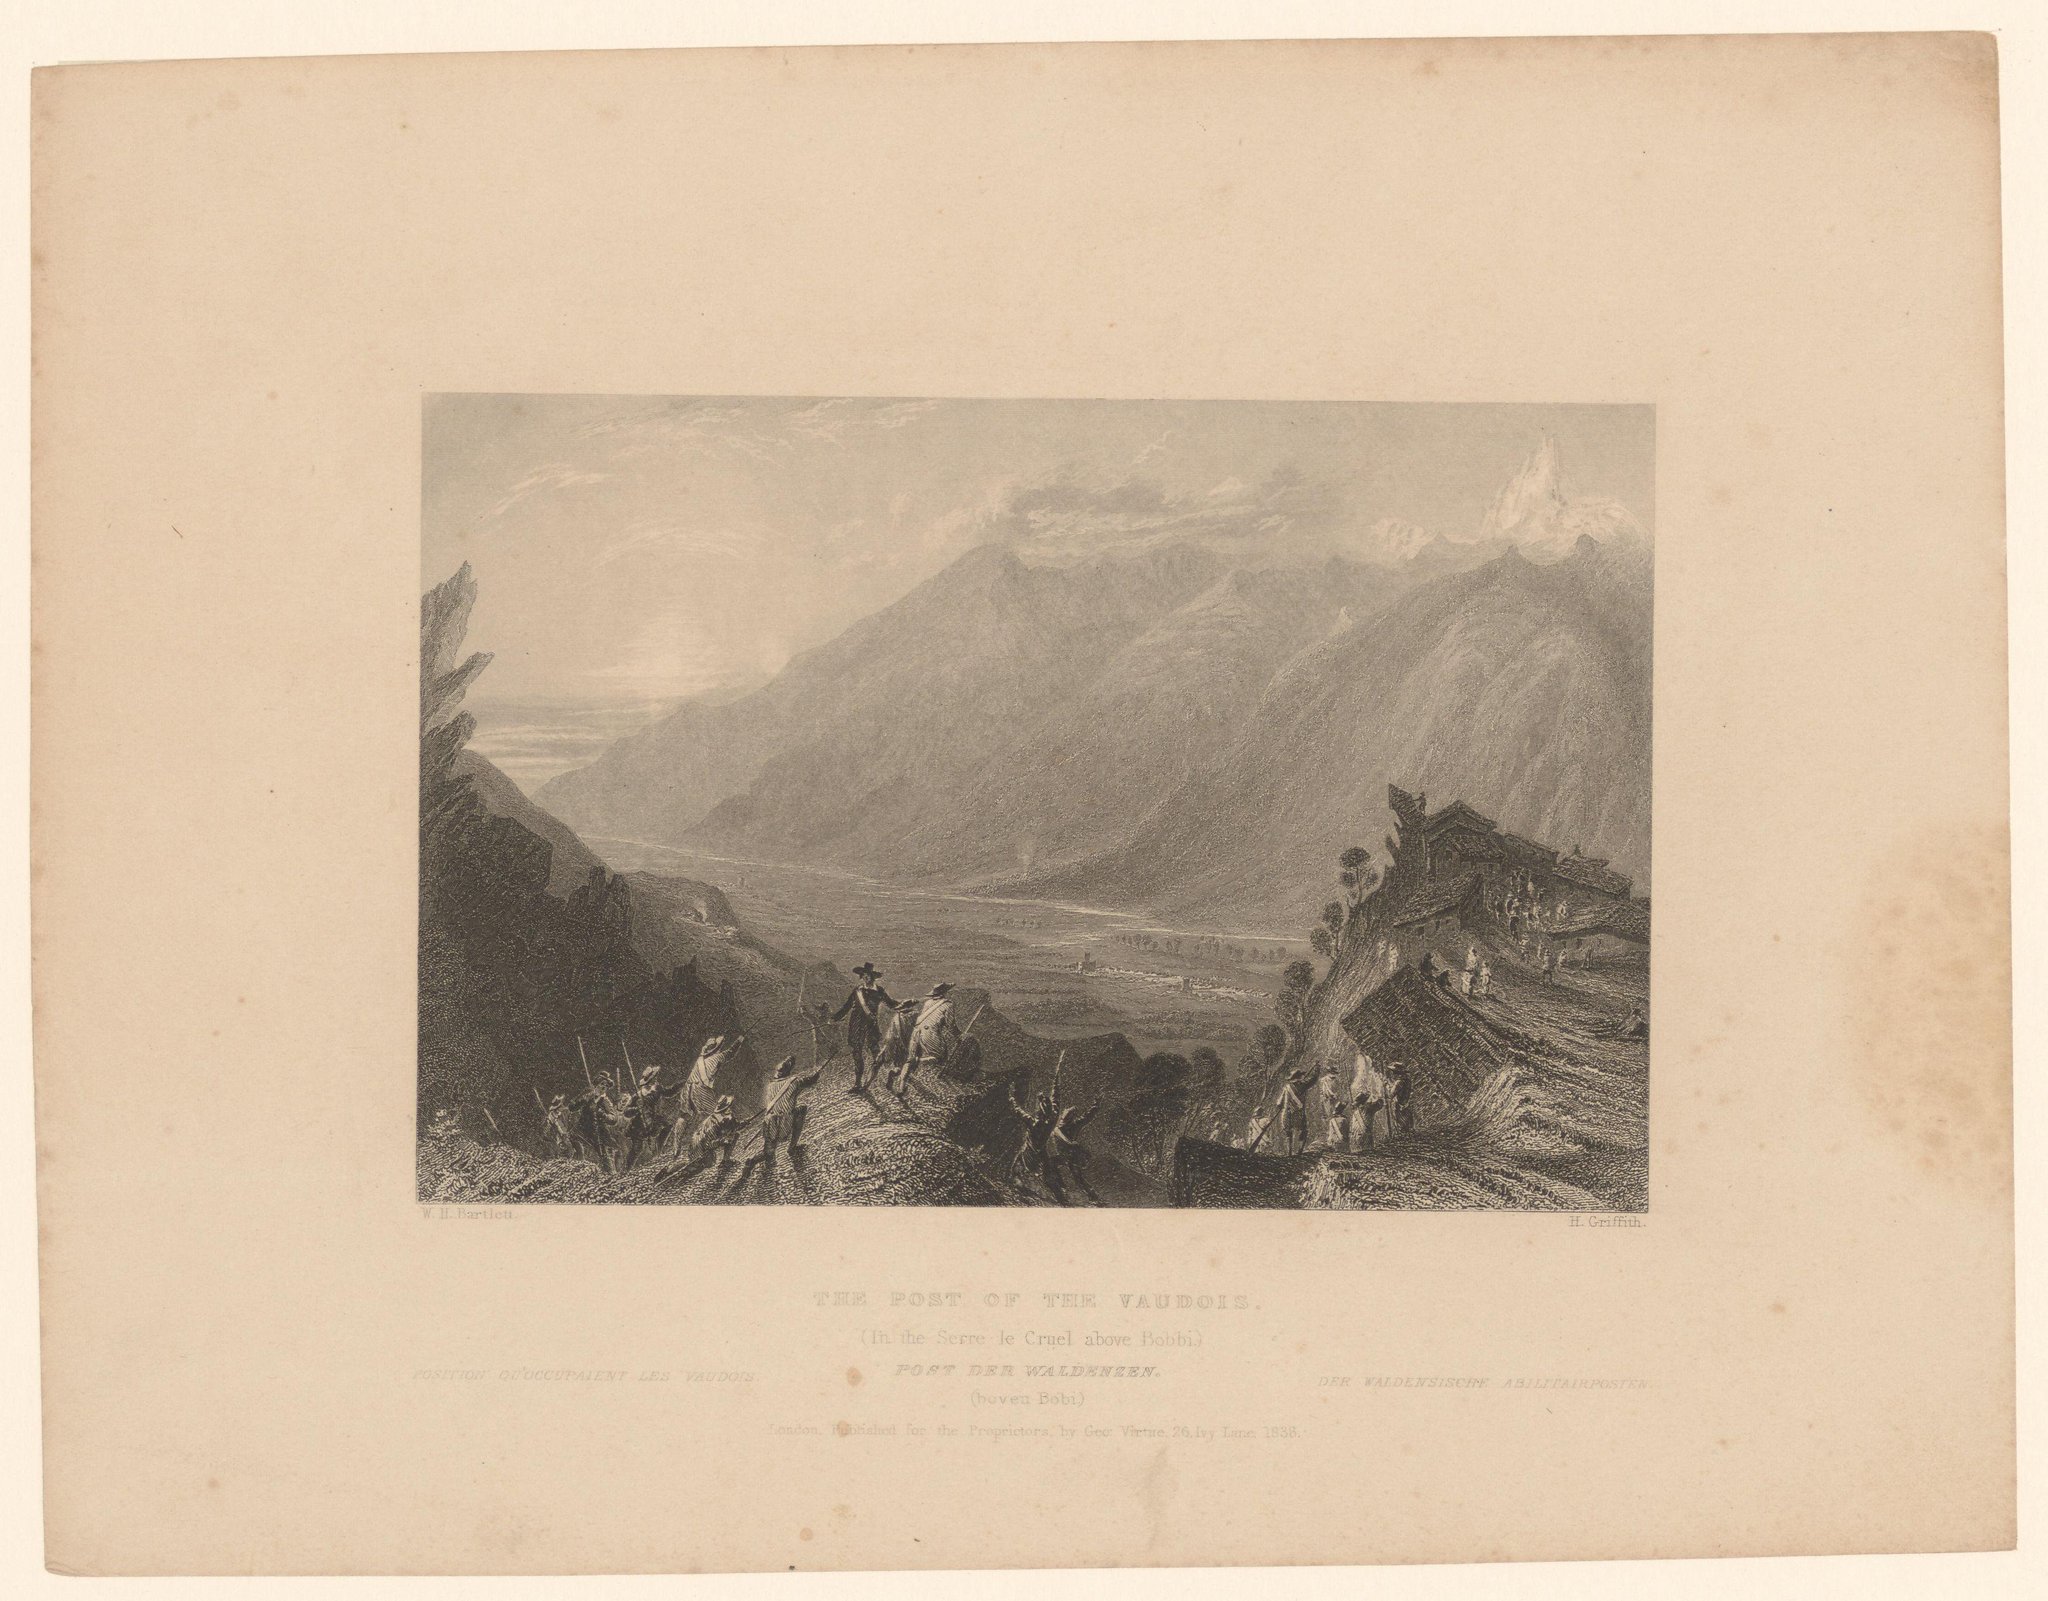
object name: print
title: Dorp van Waldenzen in de Alpen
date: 1838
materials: paper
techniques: etching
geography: london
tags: dale, valley, mountains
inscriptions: collector's mark: Lugt 2228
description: Prent uit: Beattie, William. The Waldenses or Protestant Valleys of Piedmont, Dauphiny, and The Ban de la Roche. Londen: George Virtue, 1838.